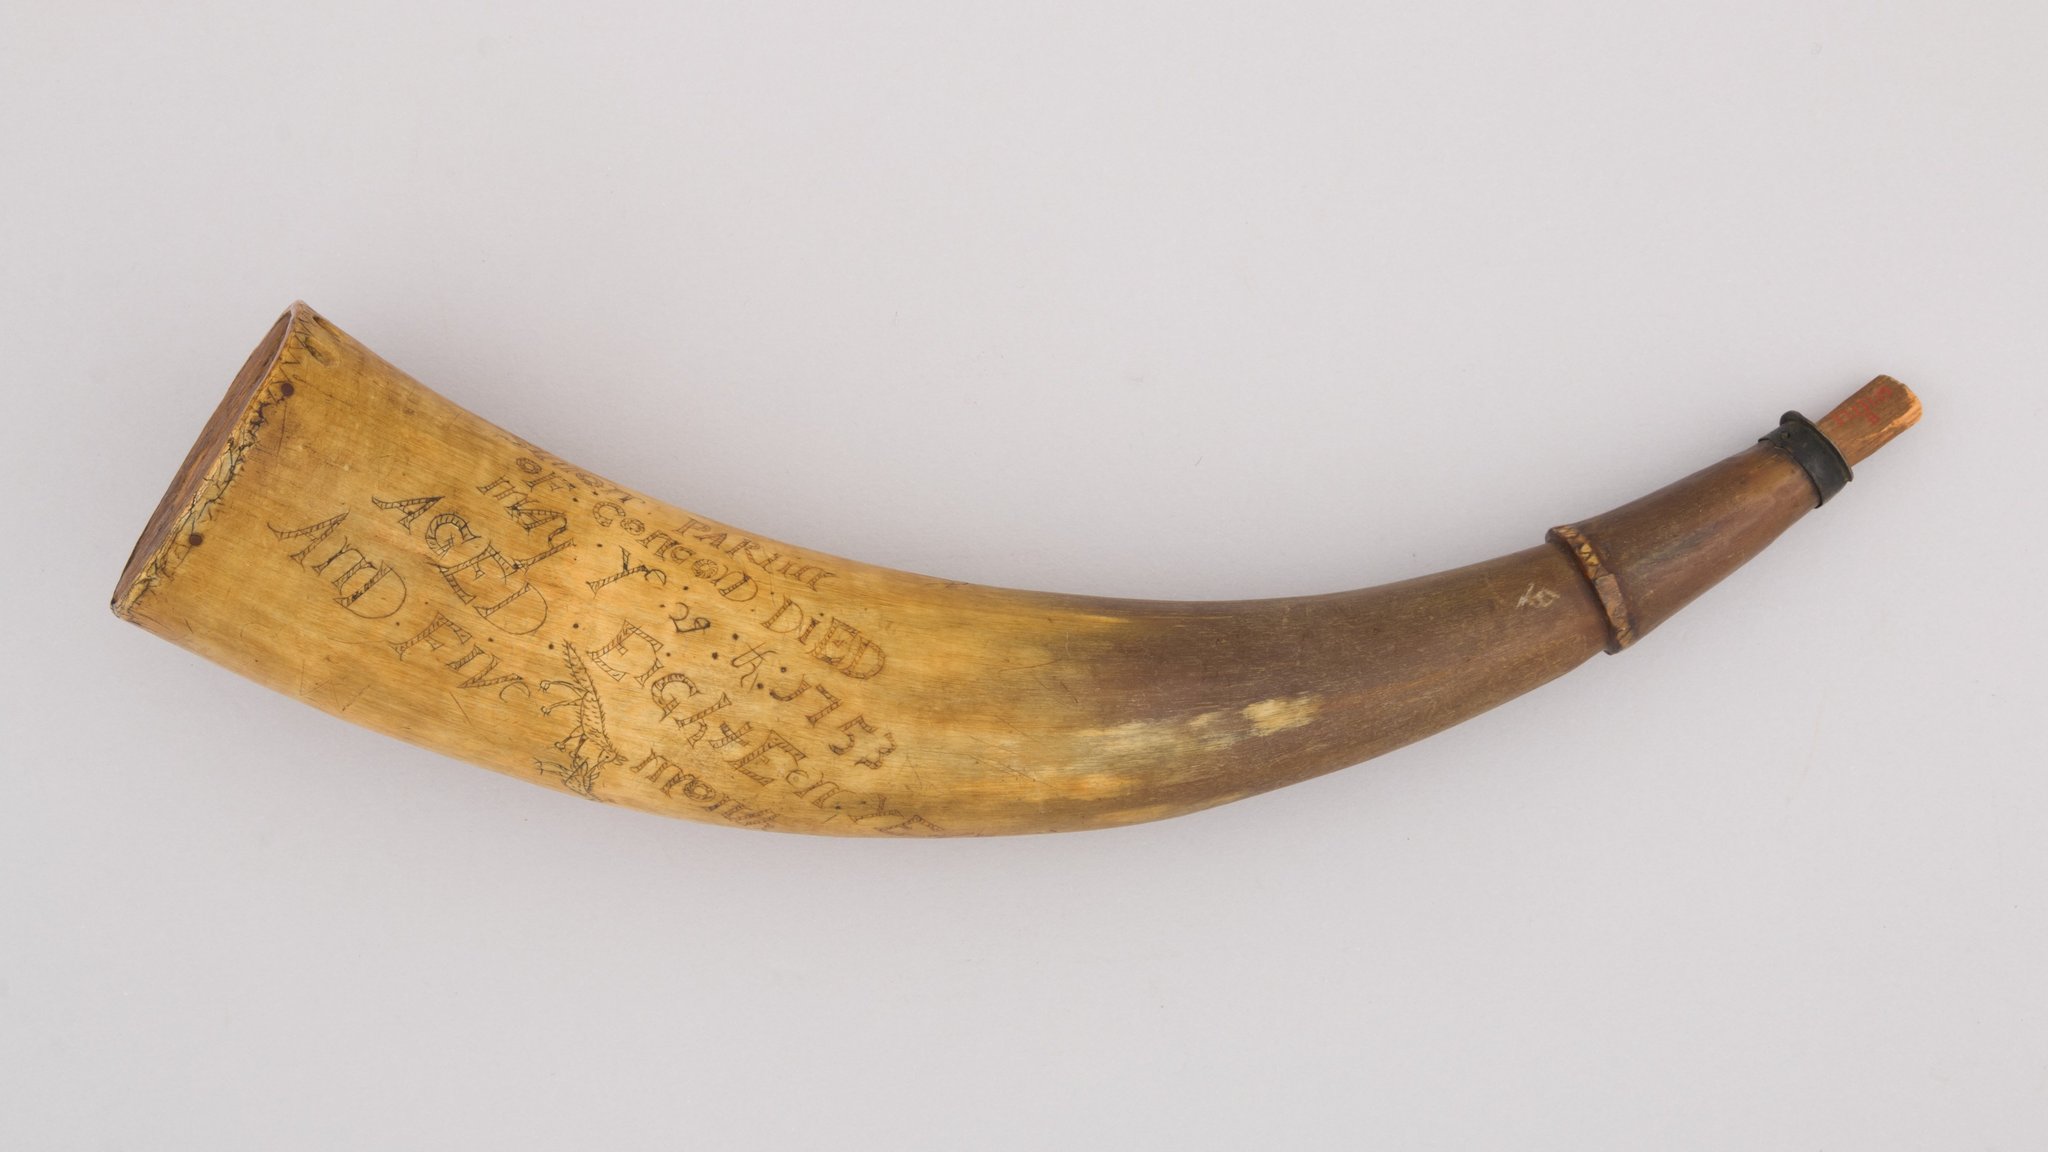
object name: powder horn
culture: colonial american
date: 1753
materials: brass, horn, wood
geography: united states